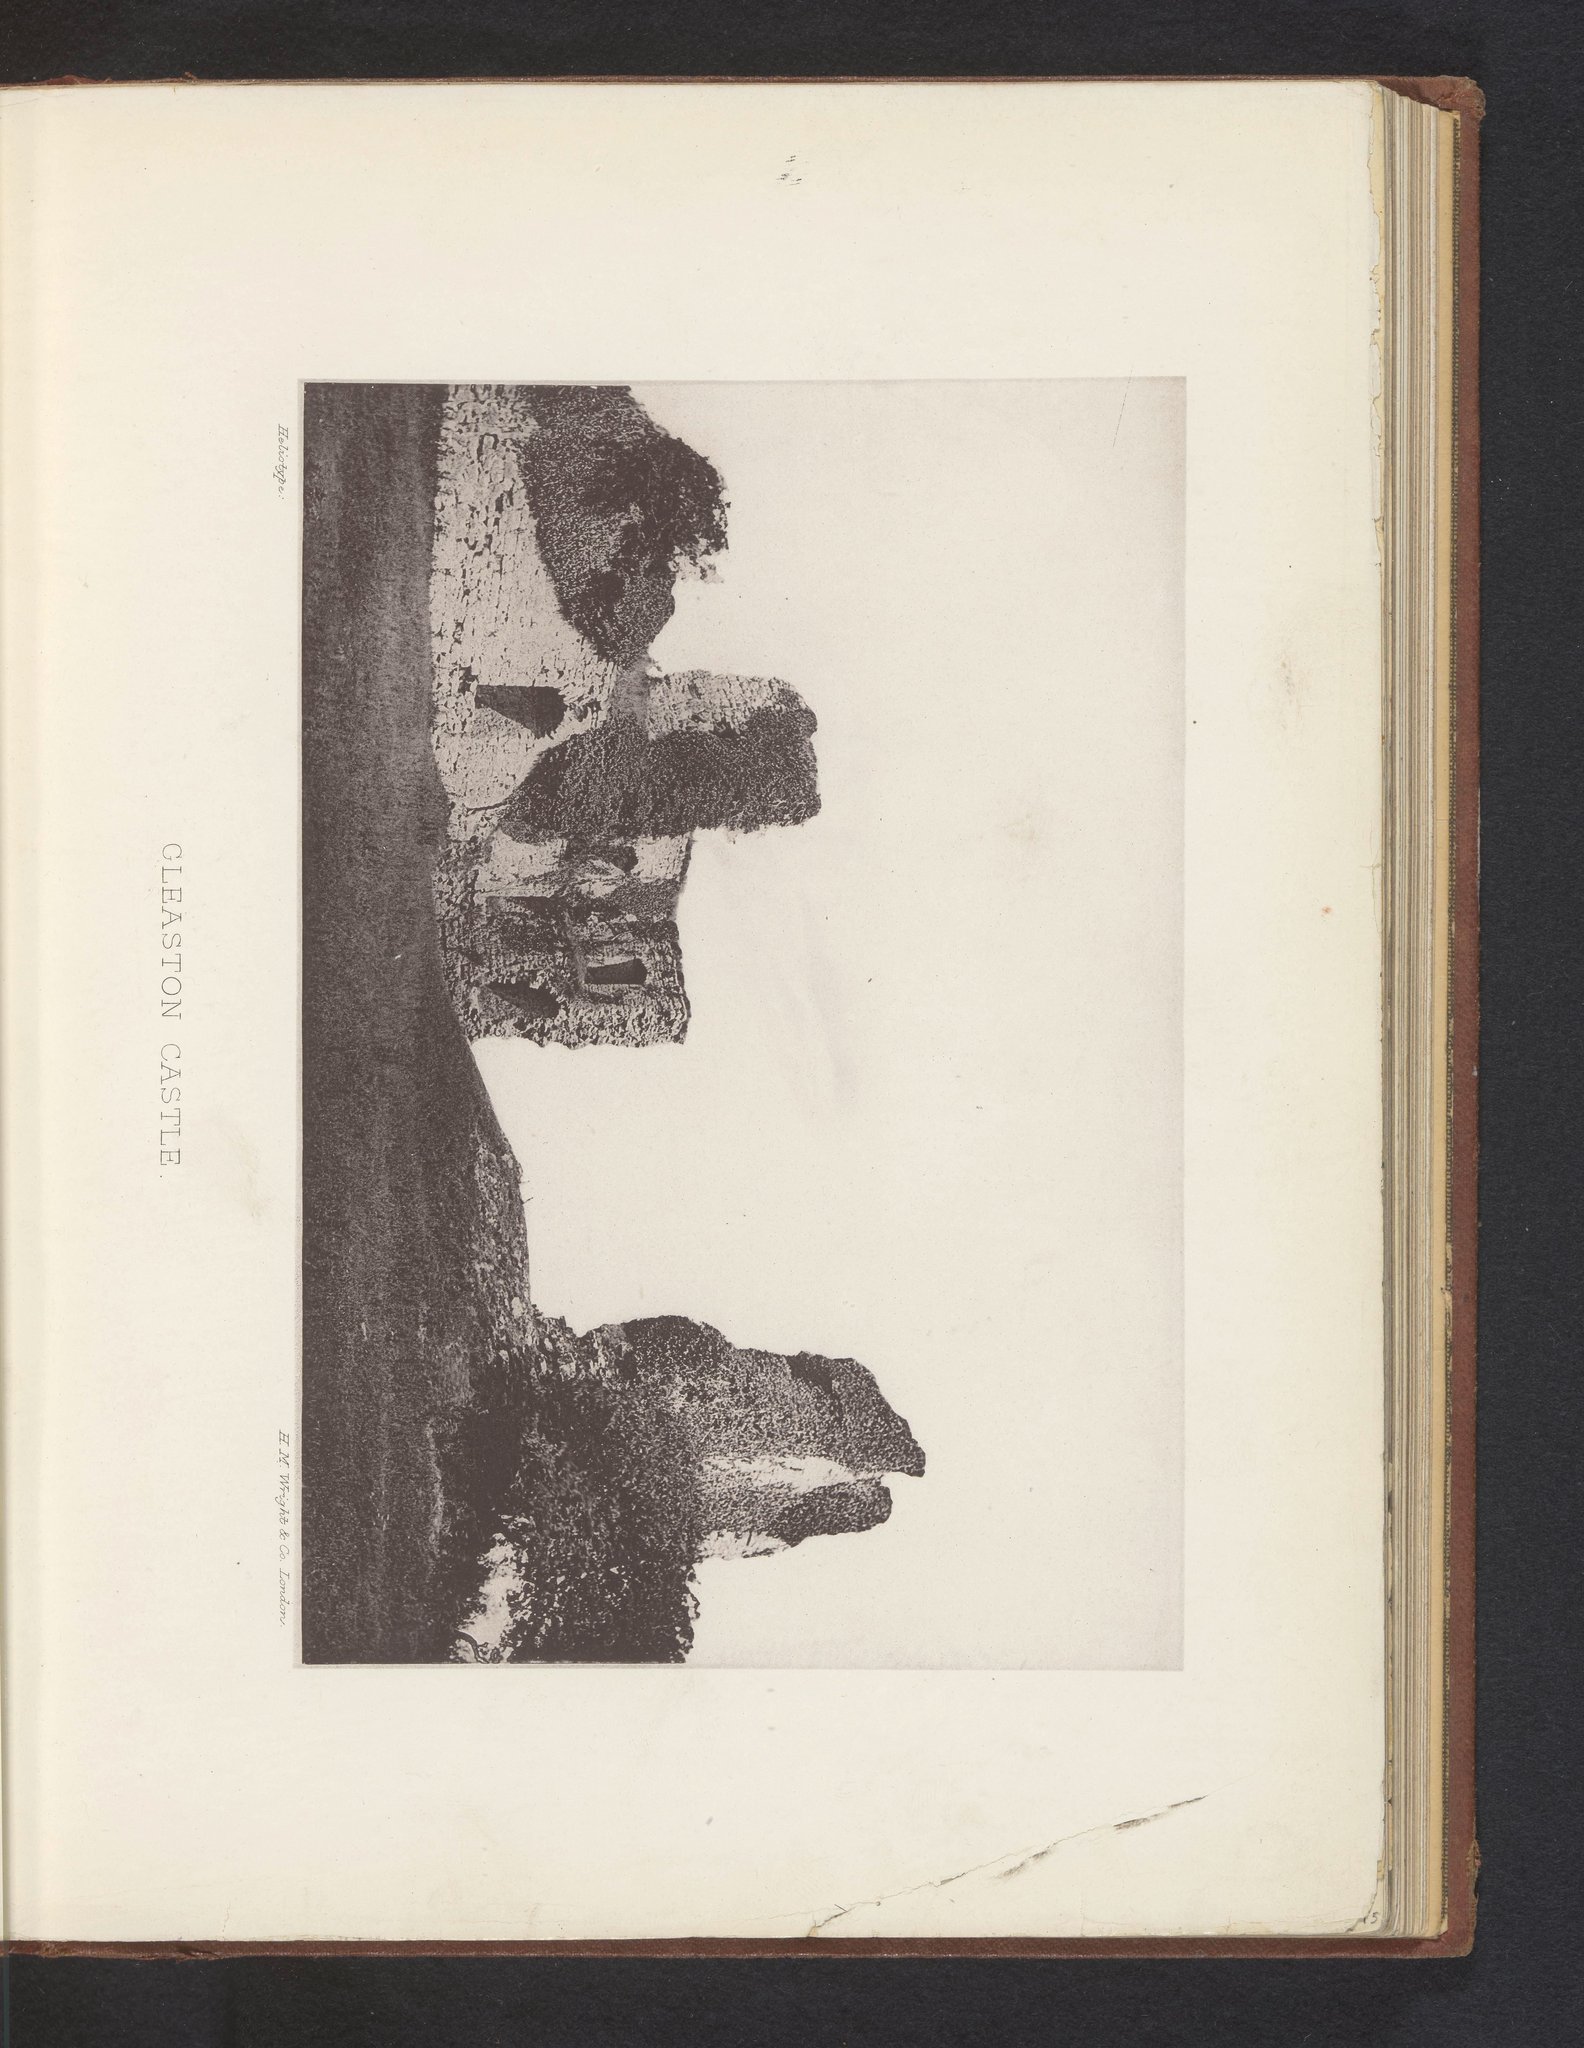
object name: page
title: Gleaston Castle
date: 1870-1880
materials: paper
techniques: heliotype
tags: landscape with ruins, ruin of a dwelling, house, castle, etc.